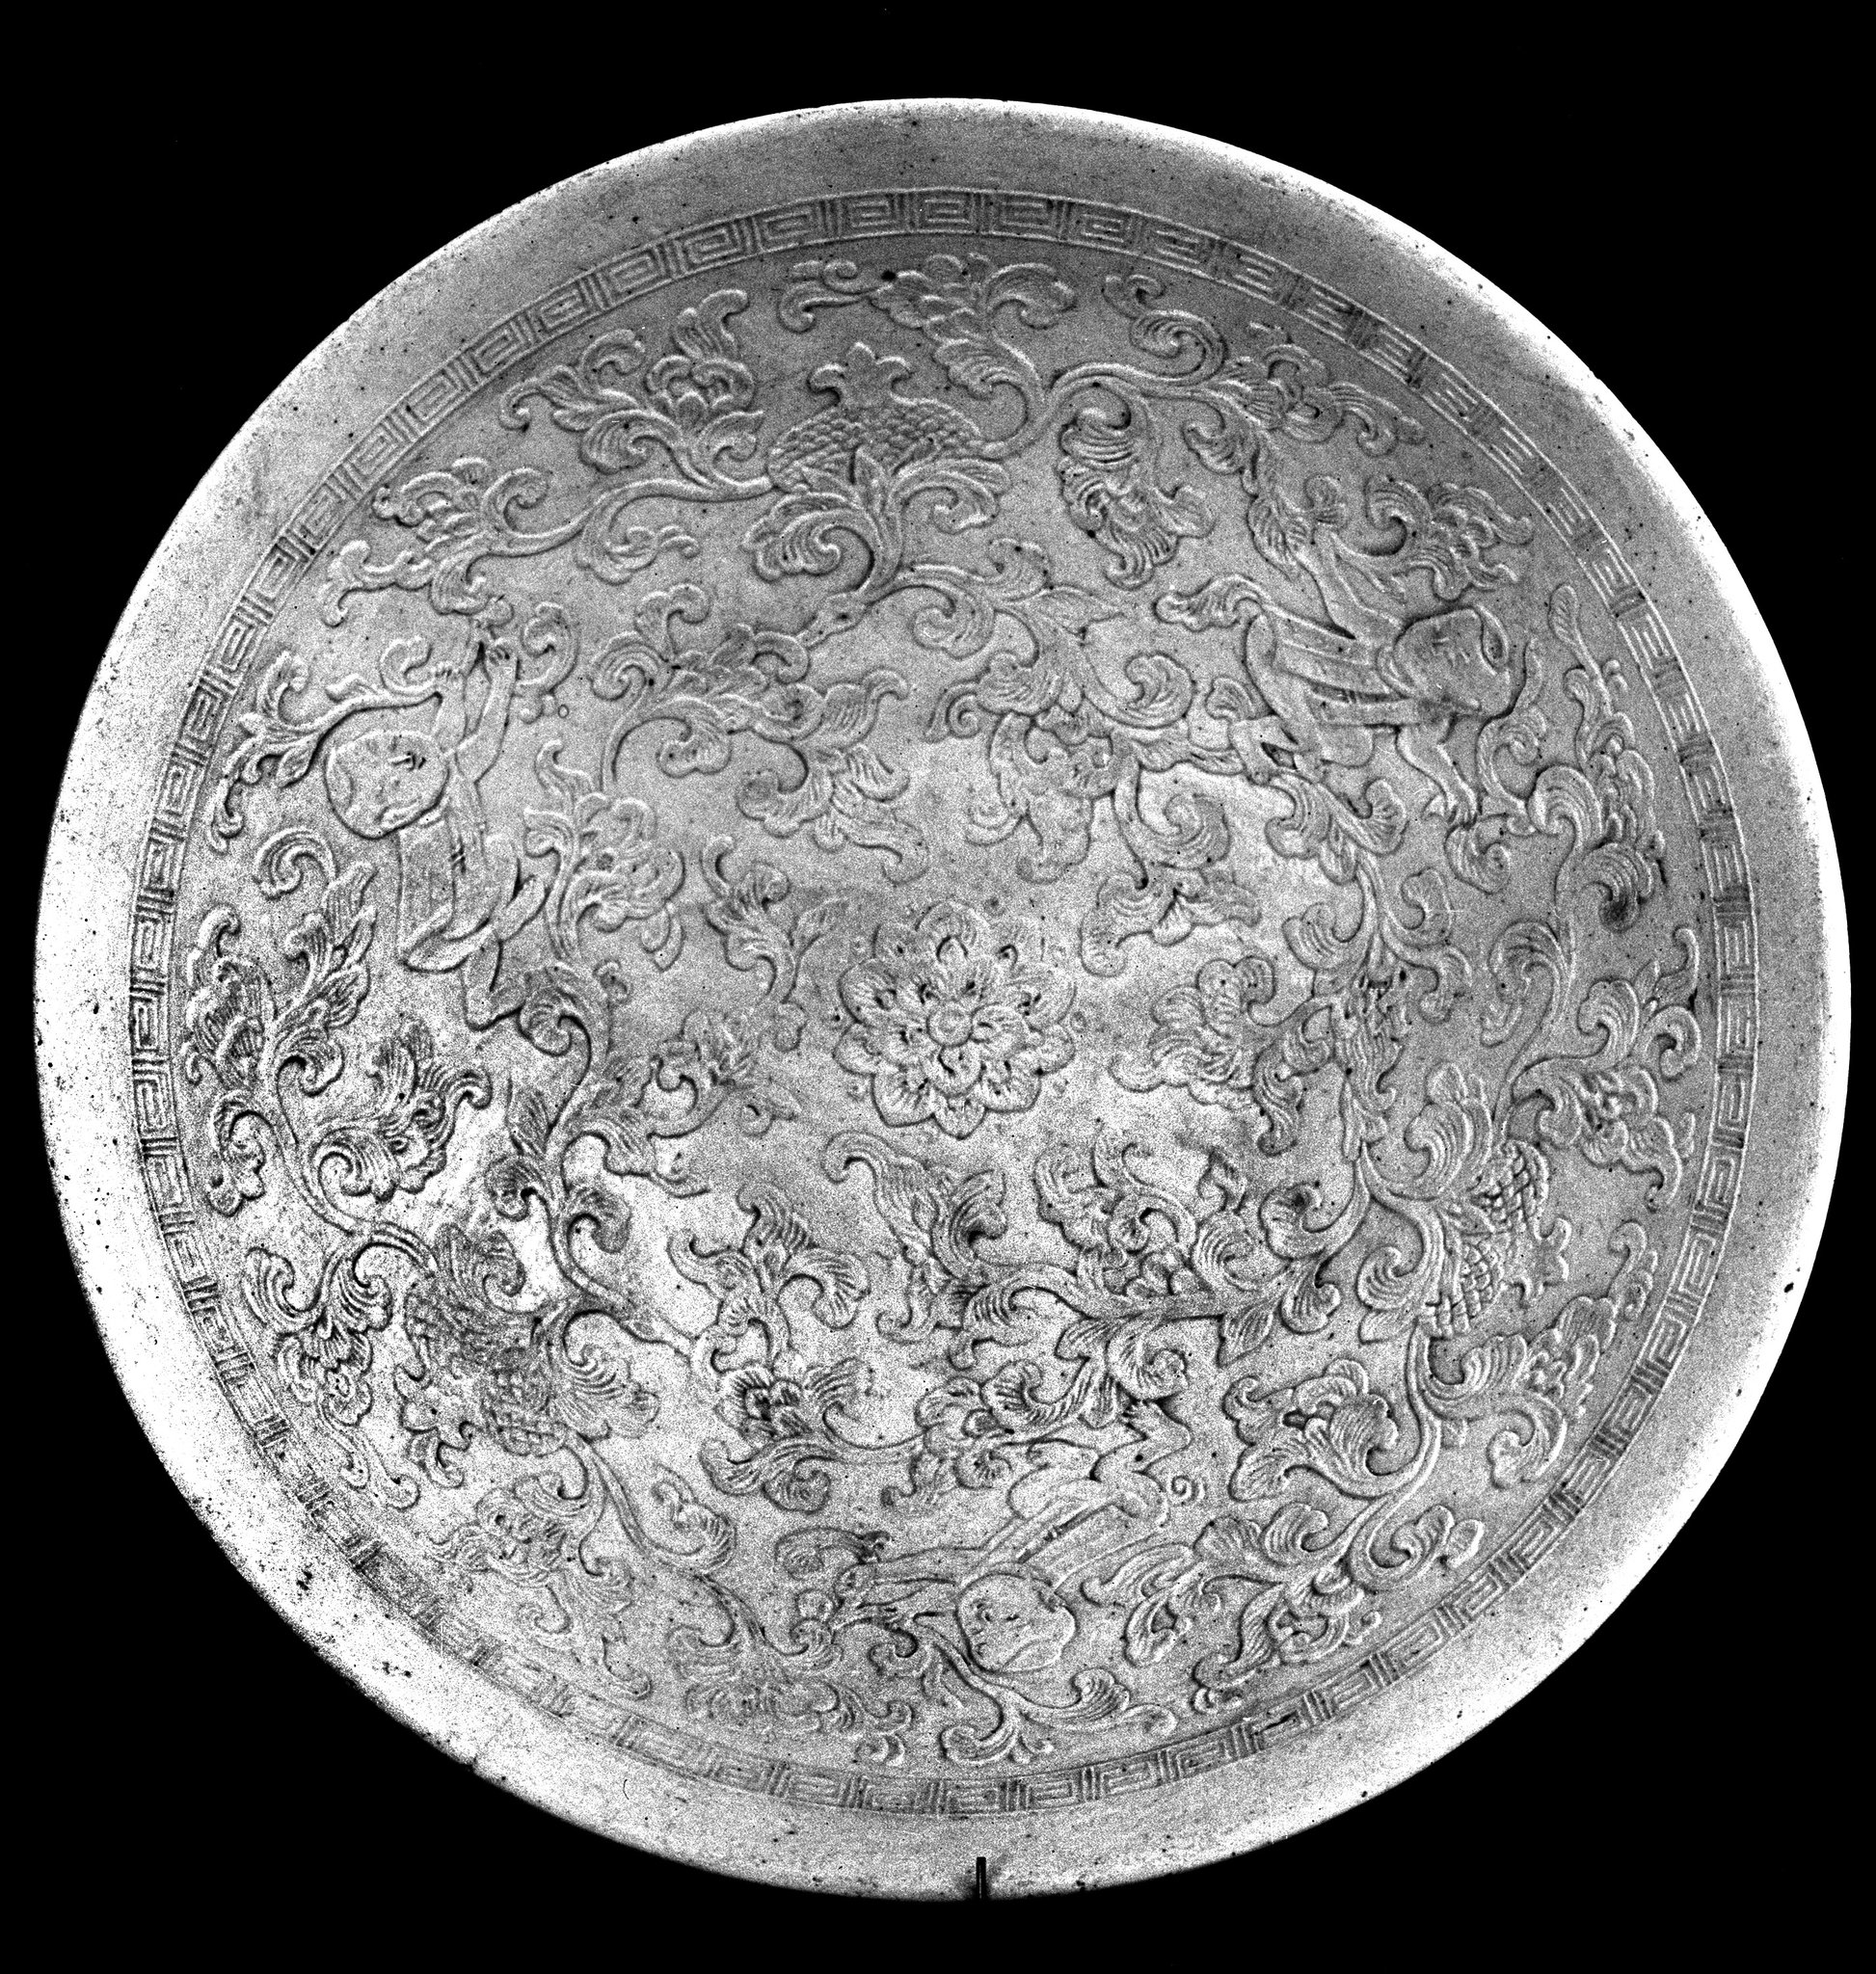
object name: bowl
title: Bowl with boys amid floral sprays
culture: chinese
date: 1701-1800